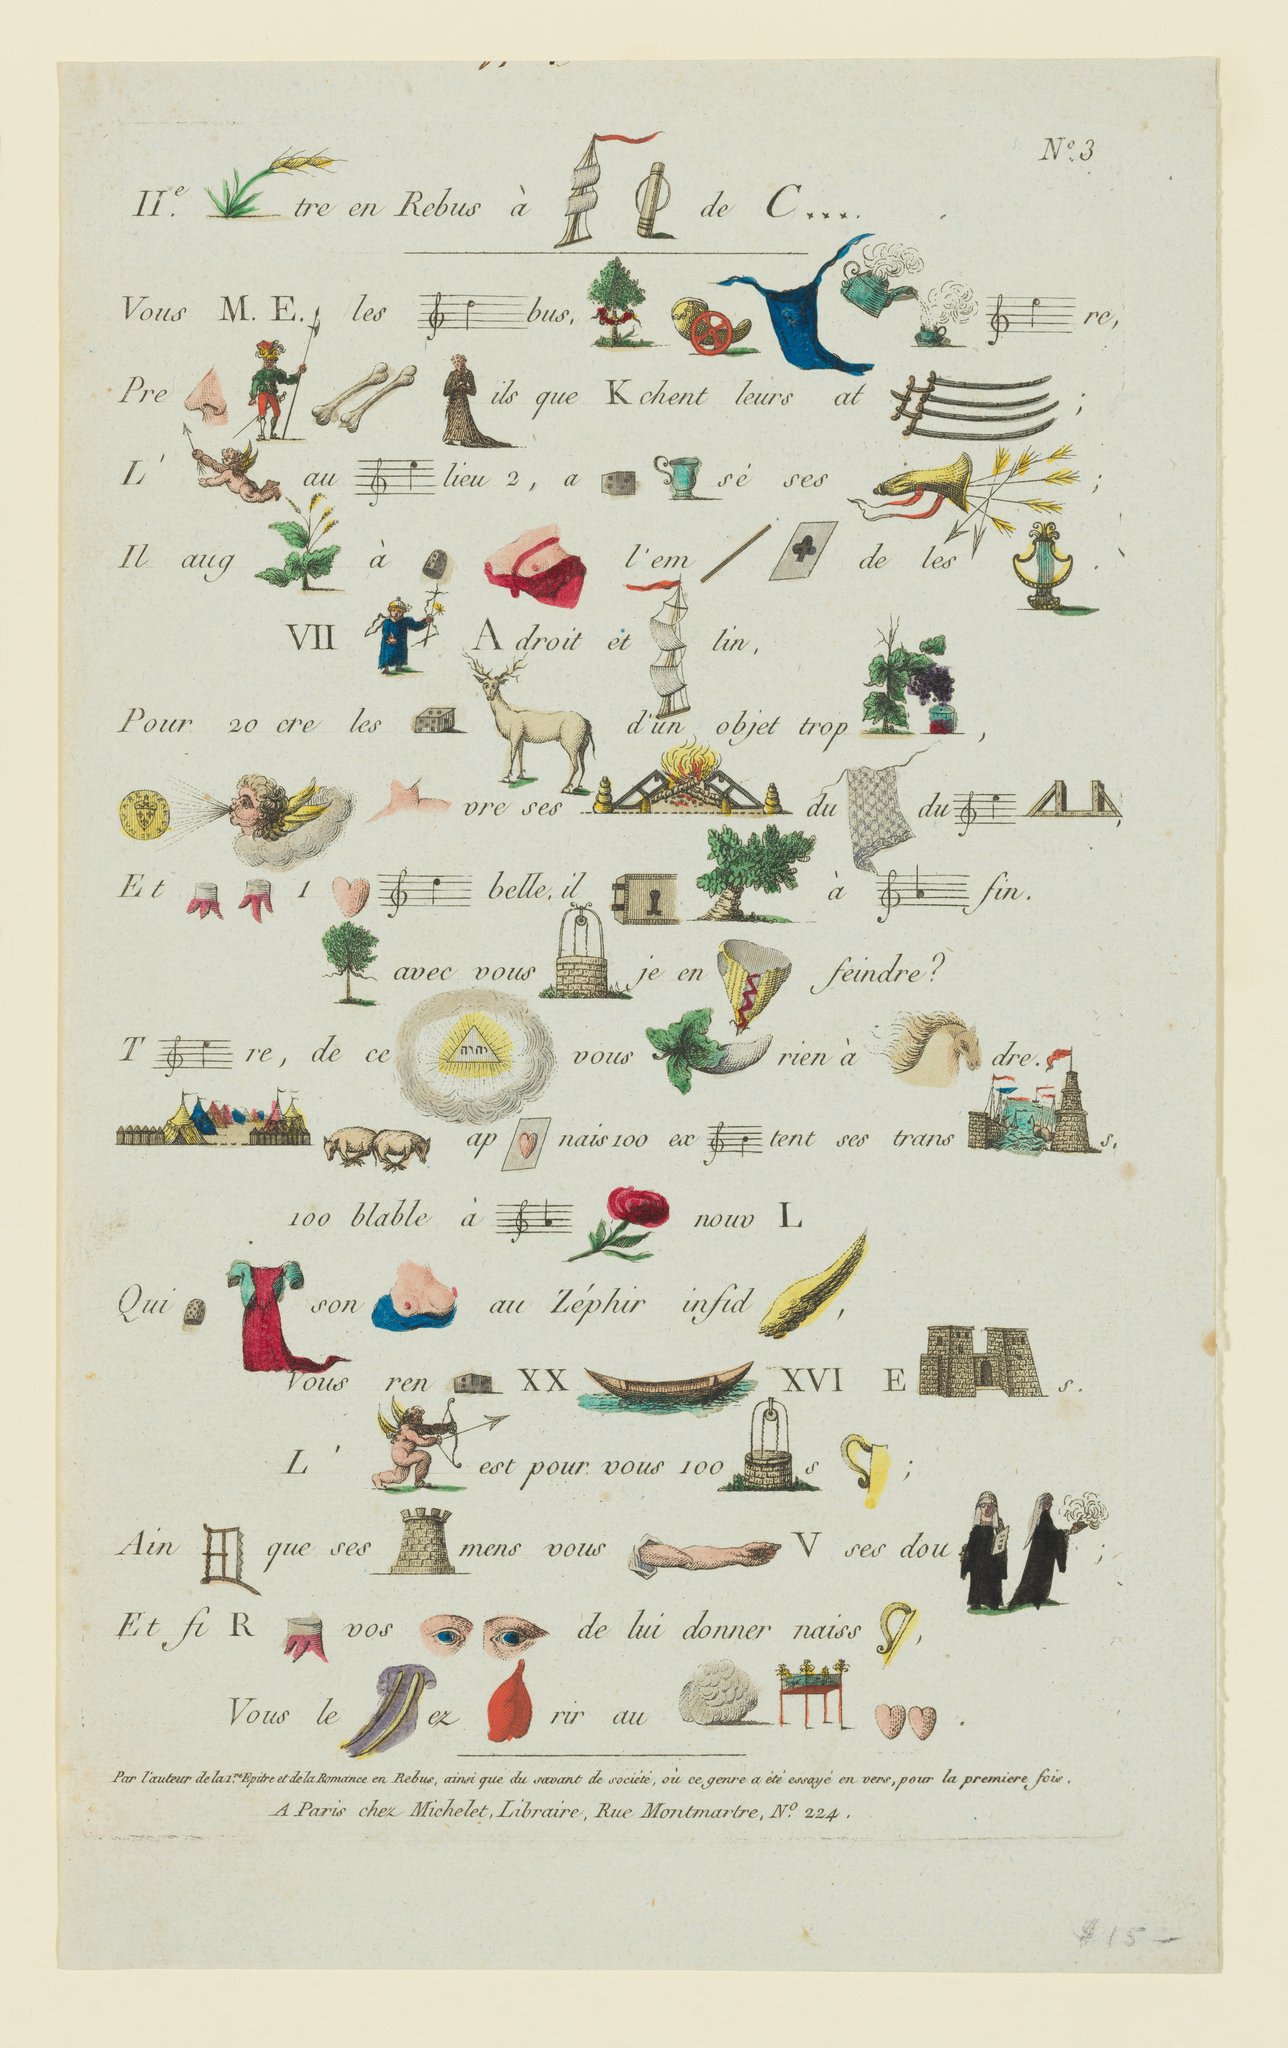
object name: print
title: Rebus Valentine Letter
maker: michelet libraire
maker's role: publisher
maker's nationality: french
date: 1840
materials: watercolor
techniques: engraving